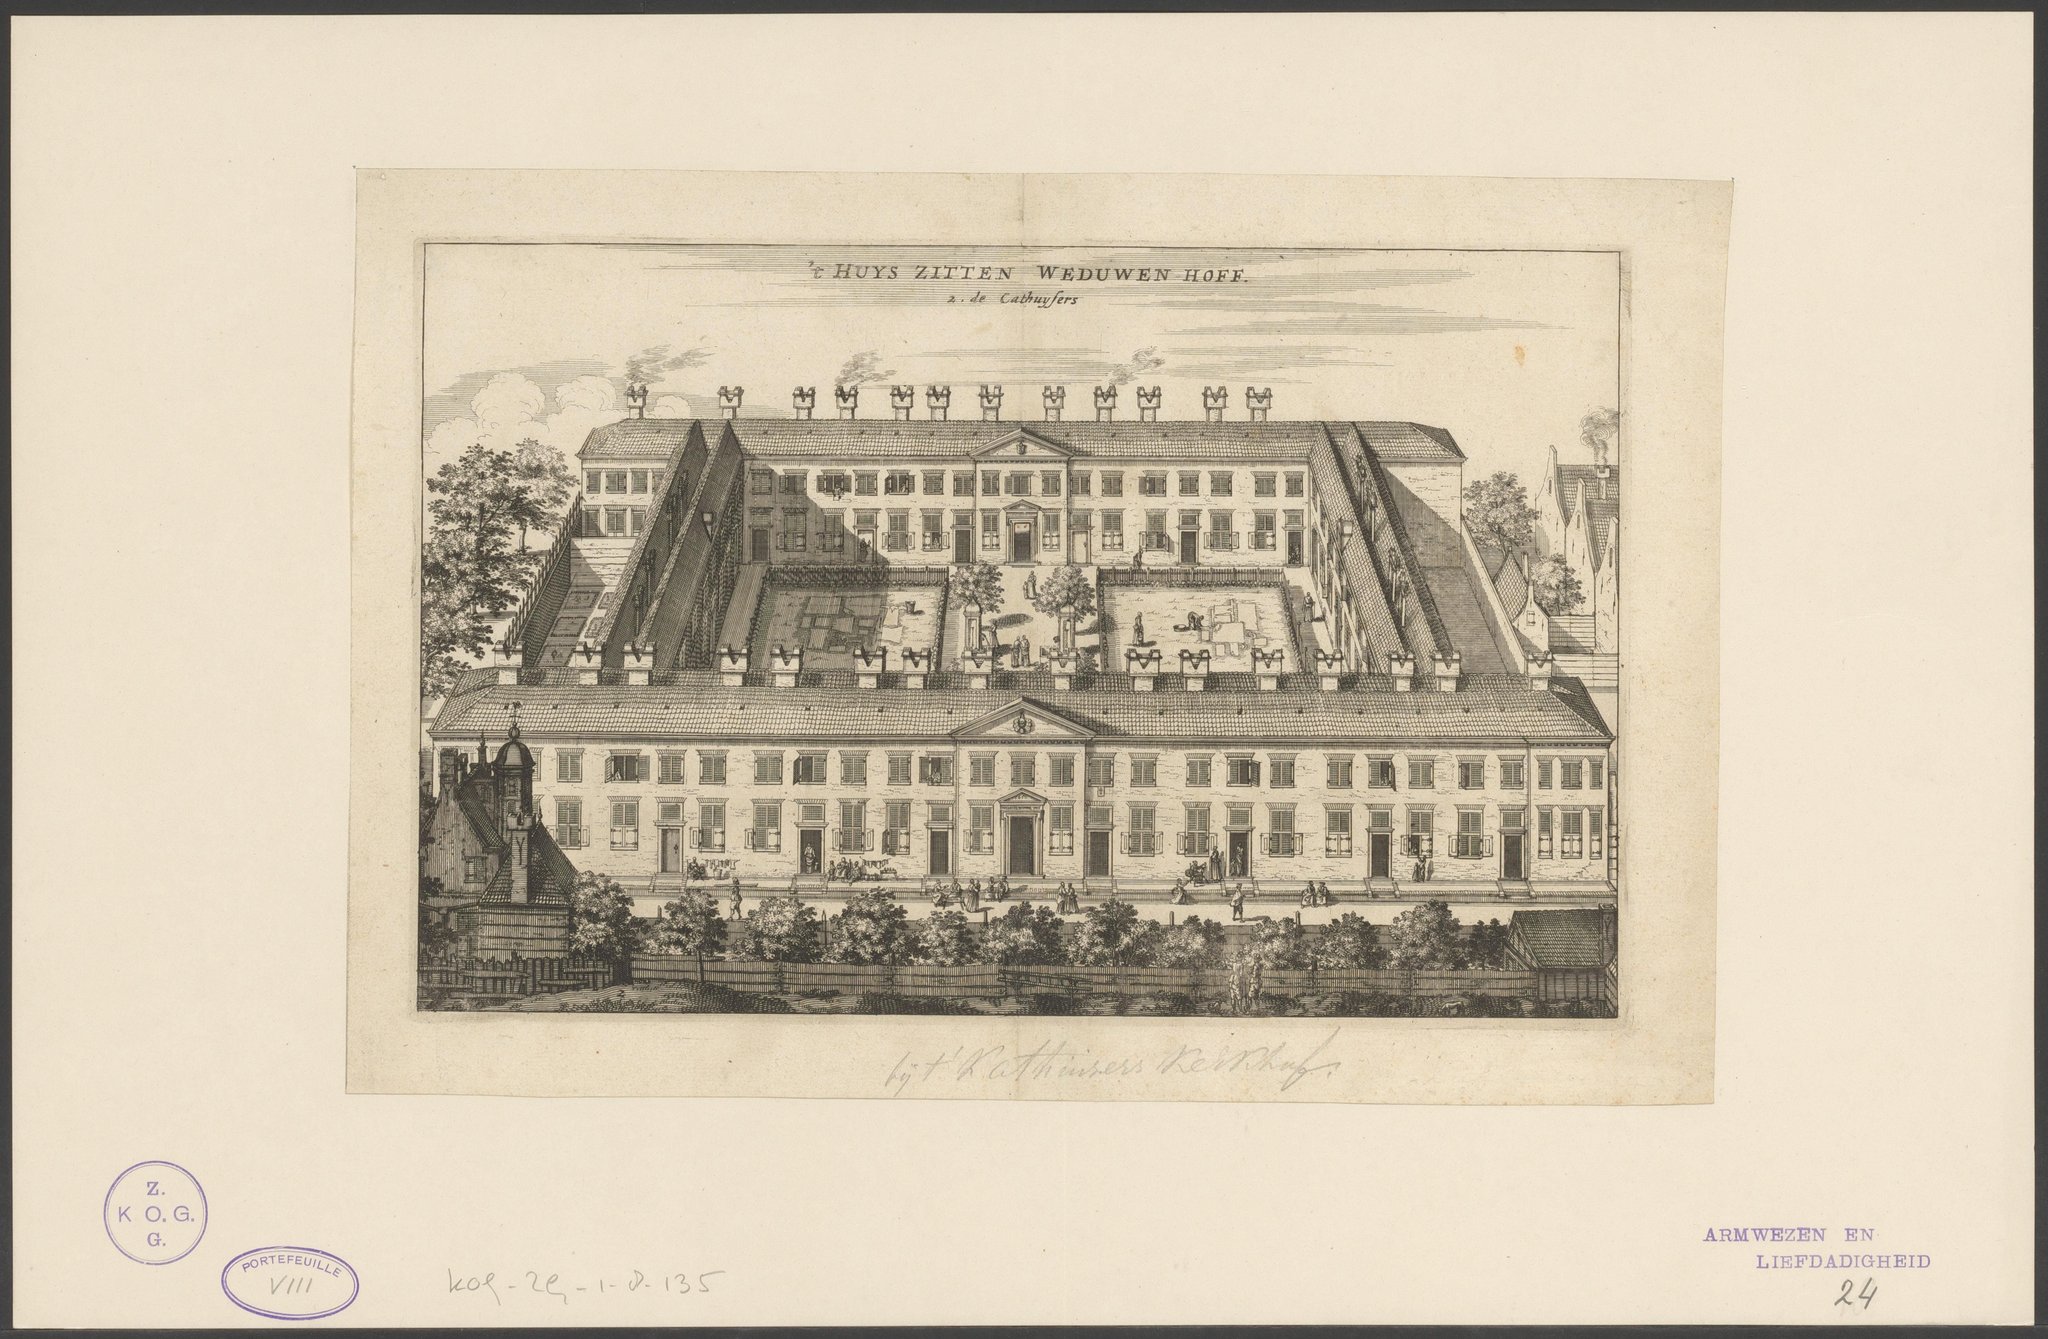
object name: print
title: 't Huys zitten Weduwen hoff. 2. de Cathuysers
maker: jacob van meurs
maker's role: draughtsman, print maker, publisher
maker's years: 1619-1680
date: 1663-1664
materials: paper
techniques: engraving, etching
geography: amsterdam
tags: public welfare, poorhouse, courtyard, old-people's home, street (+ city(-scape) with figures, staffage)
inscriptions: collector's mark: Lugt 1641, collector's mark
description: Huidige staat van prent ook gebruikt in: Dapper, Olfert. Historische beschryving der stadt Amsterdam: waer in de voornaemste geschiedenissen (na een kort verhael van gansch Hollant en d'omleggende dorpen (…). Amsterdam: Jacob van Meurs, 1663.* En in: Zesen, Philipp von. Beschreibung der Stadt Amsterdam: darinnen von derselben ersten Ursprunge bis auf gegenwärtigen Zustand (…). Amsterdam: Joachim Nosche, 1664.